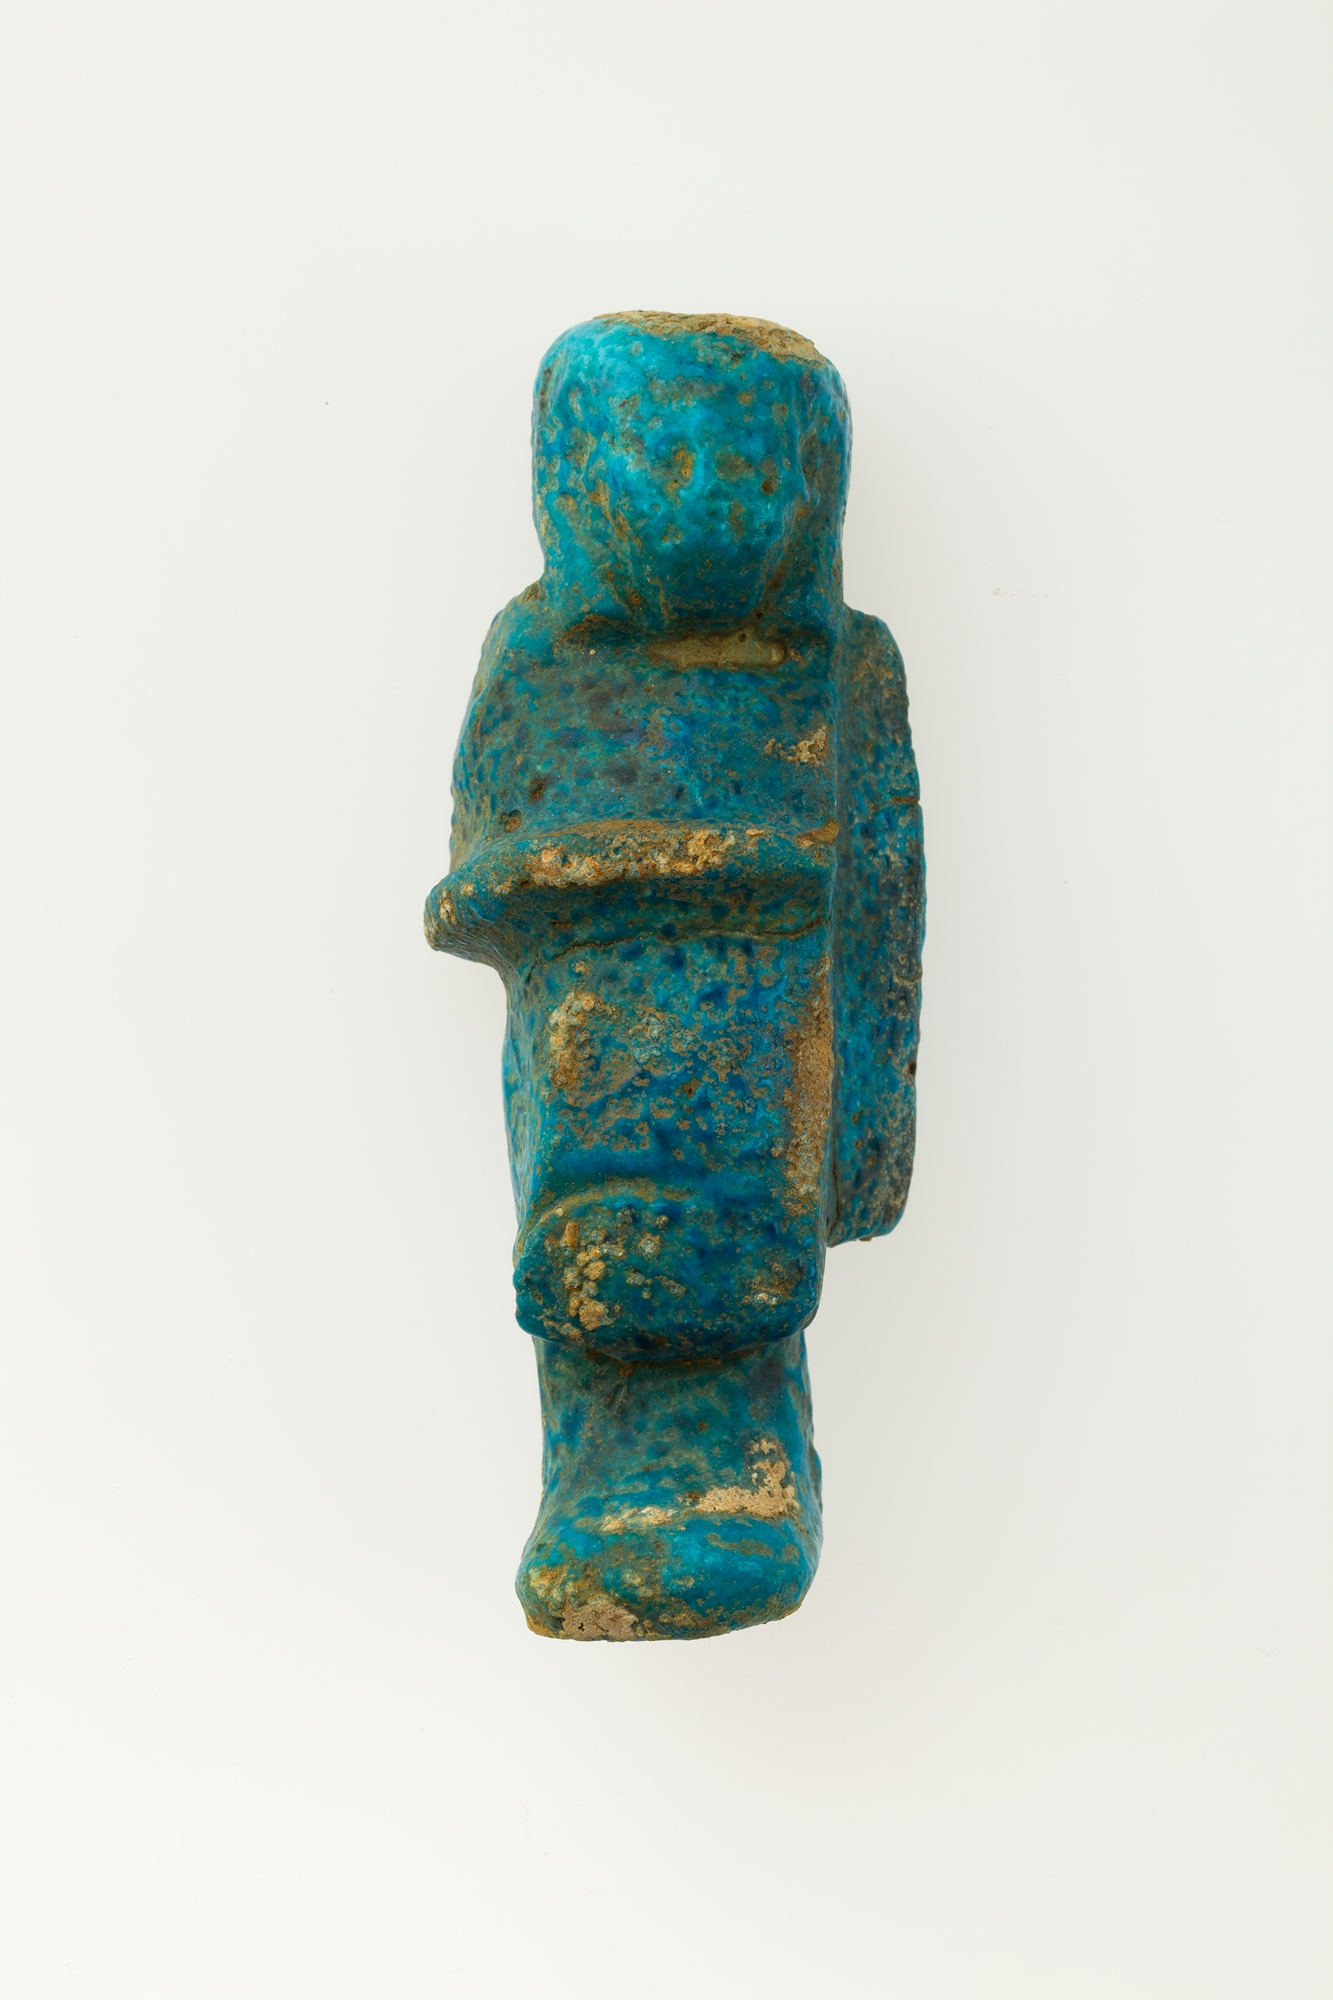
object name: shabti, henettawy c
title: Overseer Shabti of Henettawy (C), Daughter of Isetemkheb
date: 990-970 BCE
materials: faience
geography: egypt